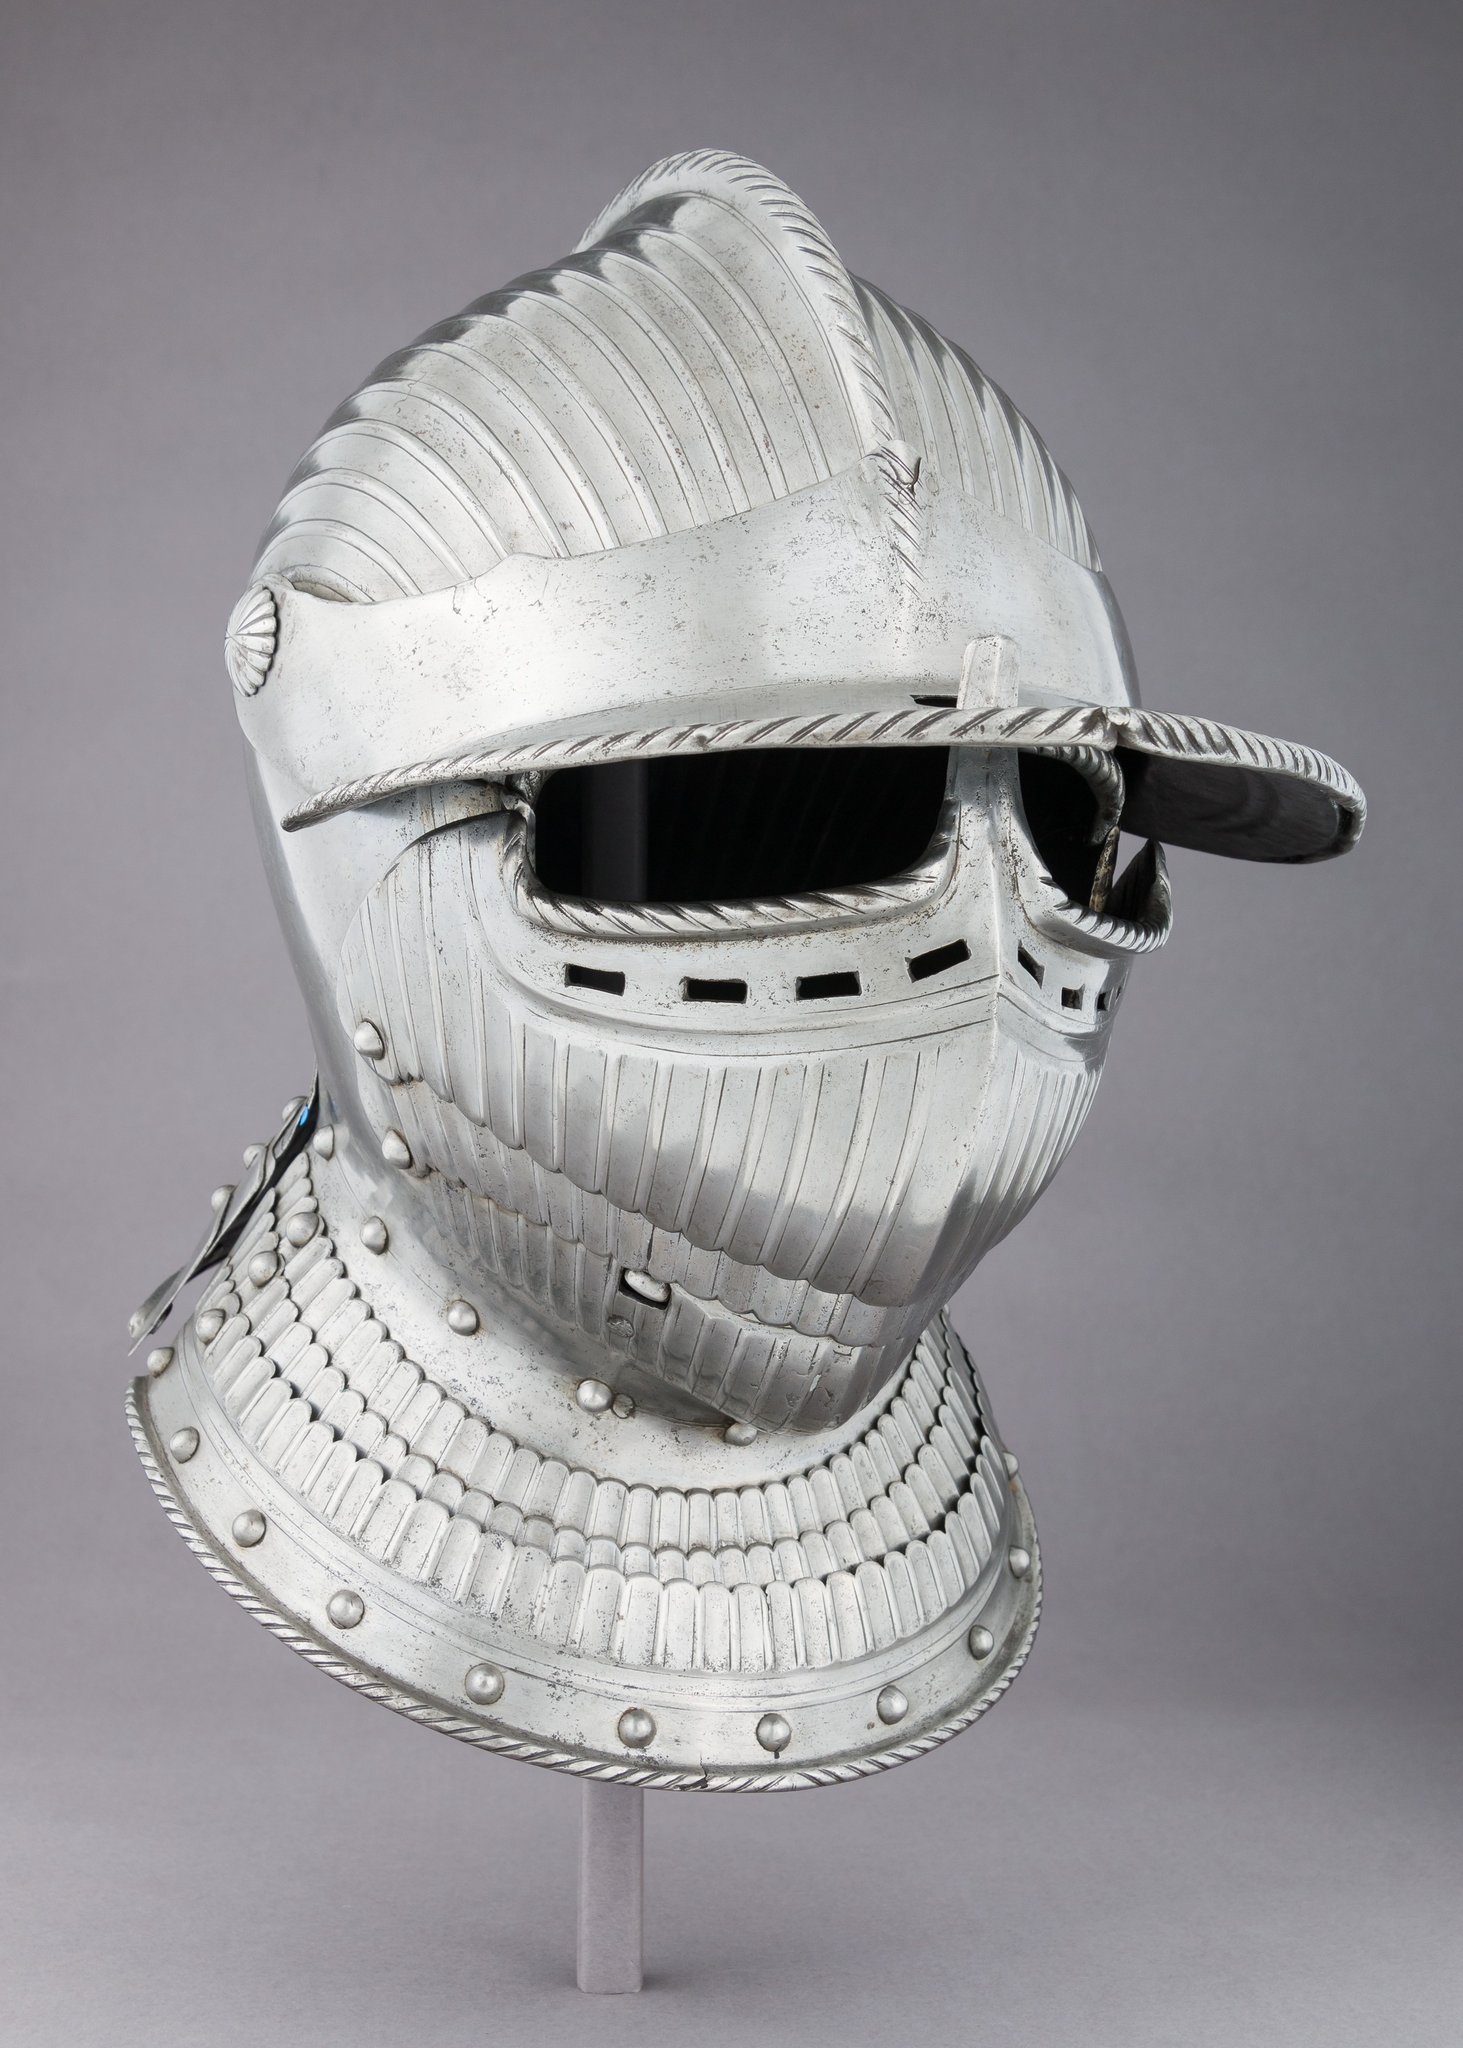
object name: burgonet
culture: german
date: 1540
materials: leather, steel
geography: germany